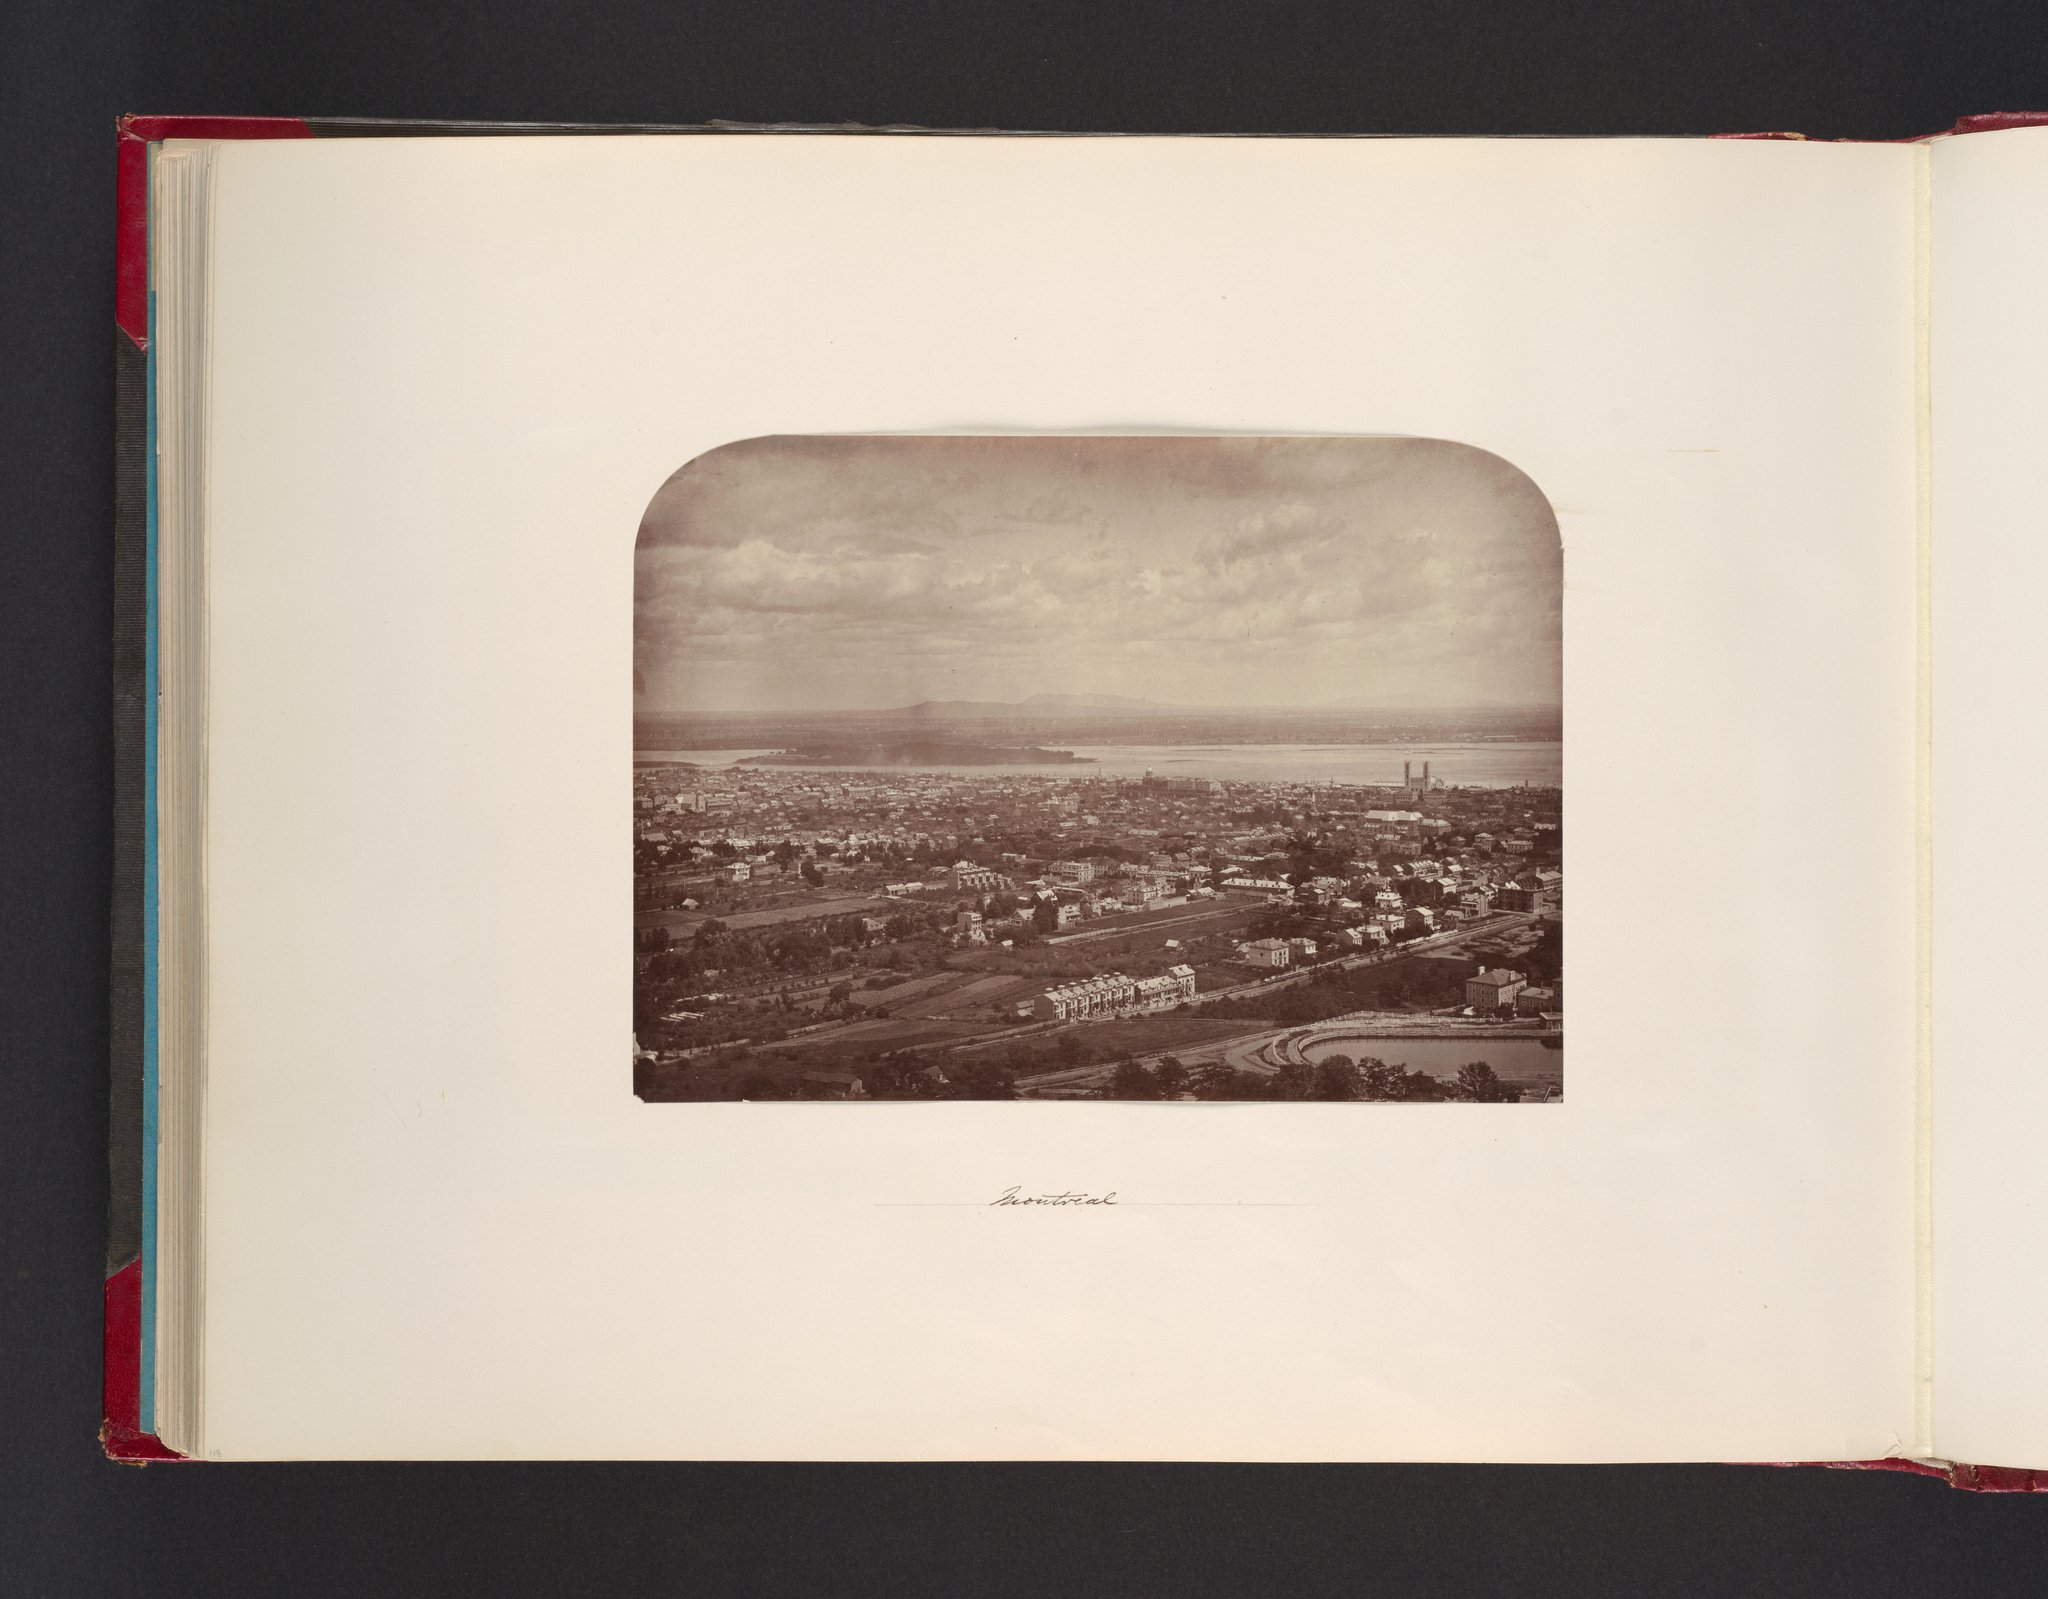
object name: photograph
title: Montreal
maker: john thomson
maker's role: artist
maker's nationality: british, scottish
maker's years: 1837-1921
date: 1865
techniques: albumen silver print, glass negative